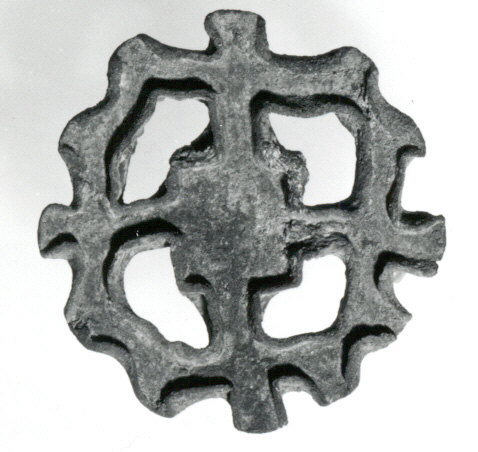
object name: stamp seal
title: Compartmented stamp seal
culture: bactria-margiana archaeological complex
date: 2333-1668 BCE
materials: copper alloy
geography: bactria-margiana